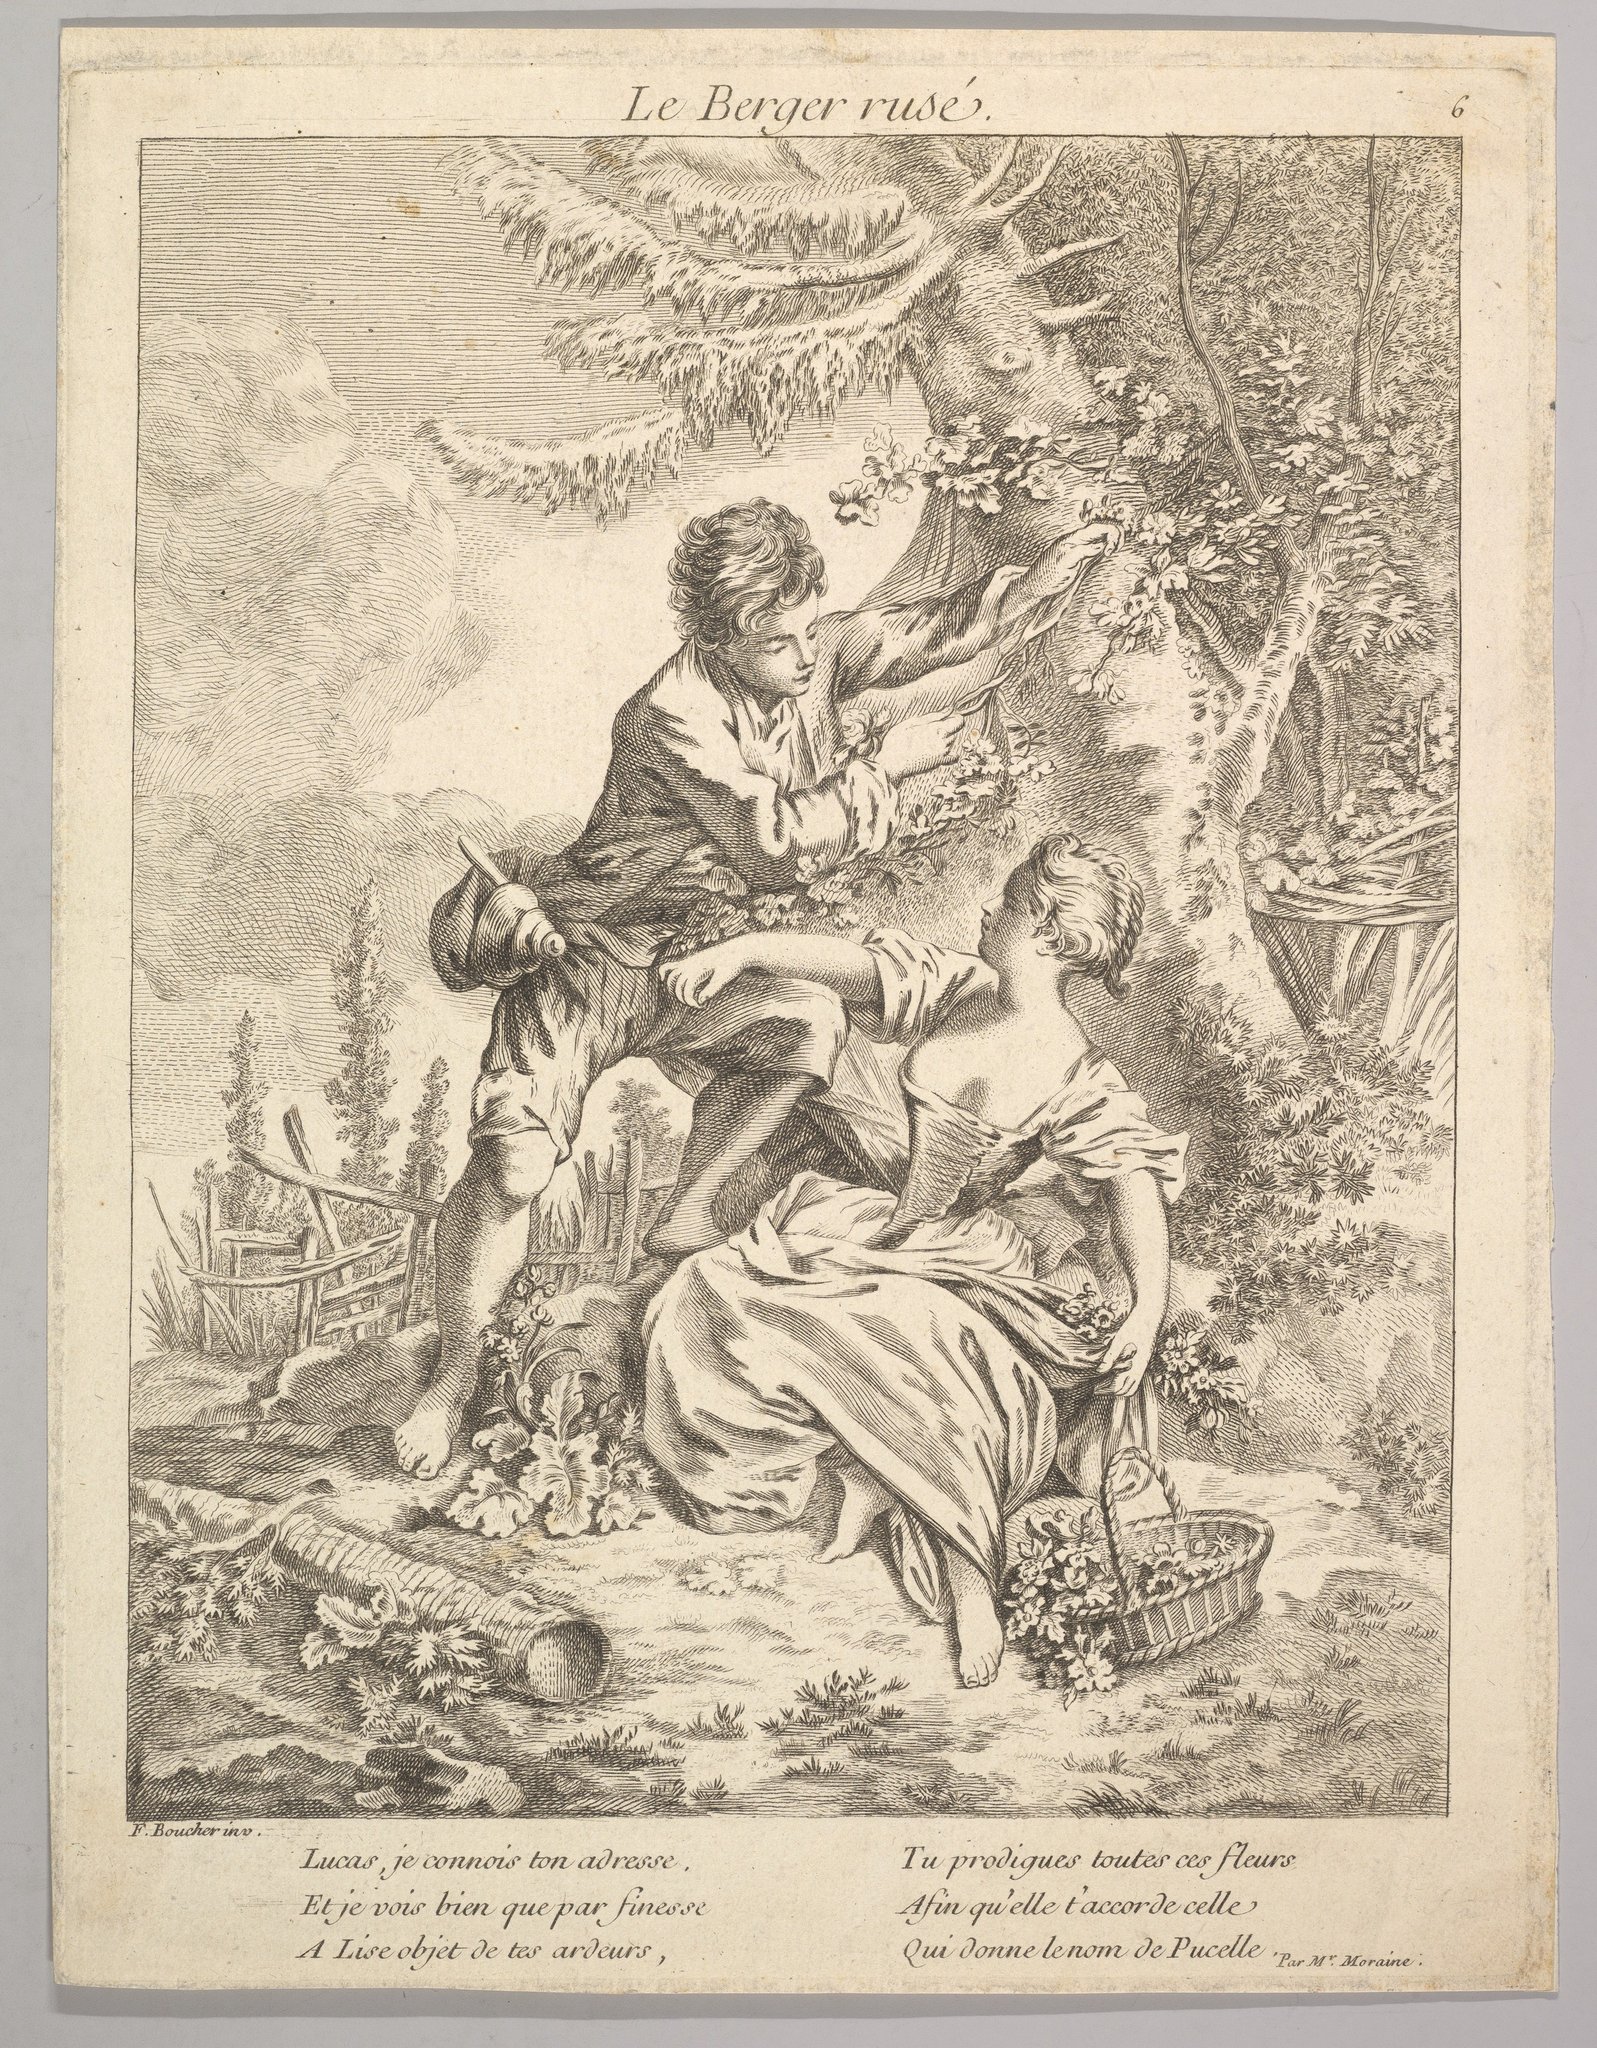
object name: print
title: The Sly Shepherd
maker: anonymous, french, 18th century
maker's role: artist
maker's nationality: french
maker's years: 1700-1800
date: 1701-1800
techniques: etching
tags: men,women,trees,shepherds